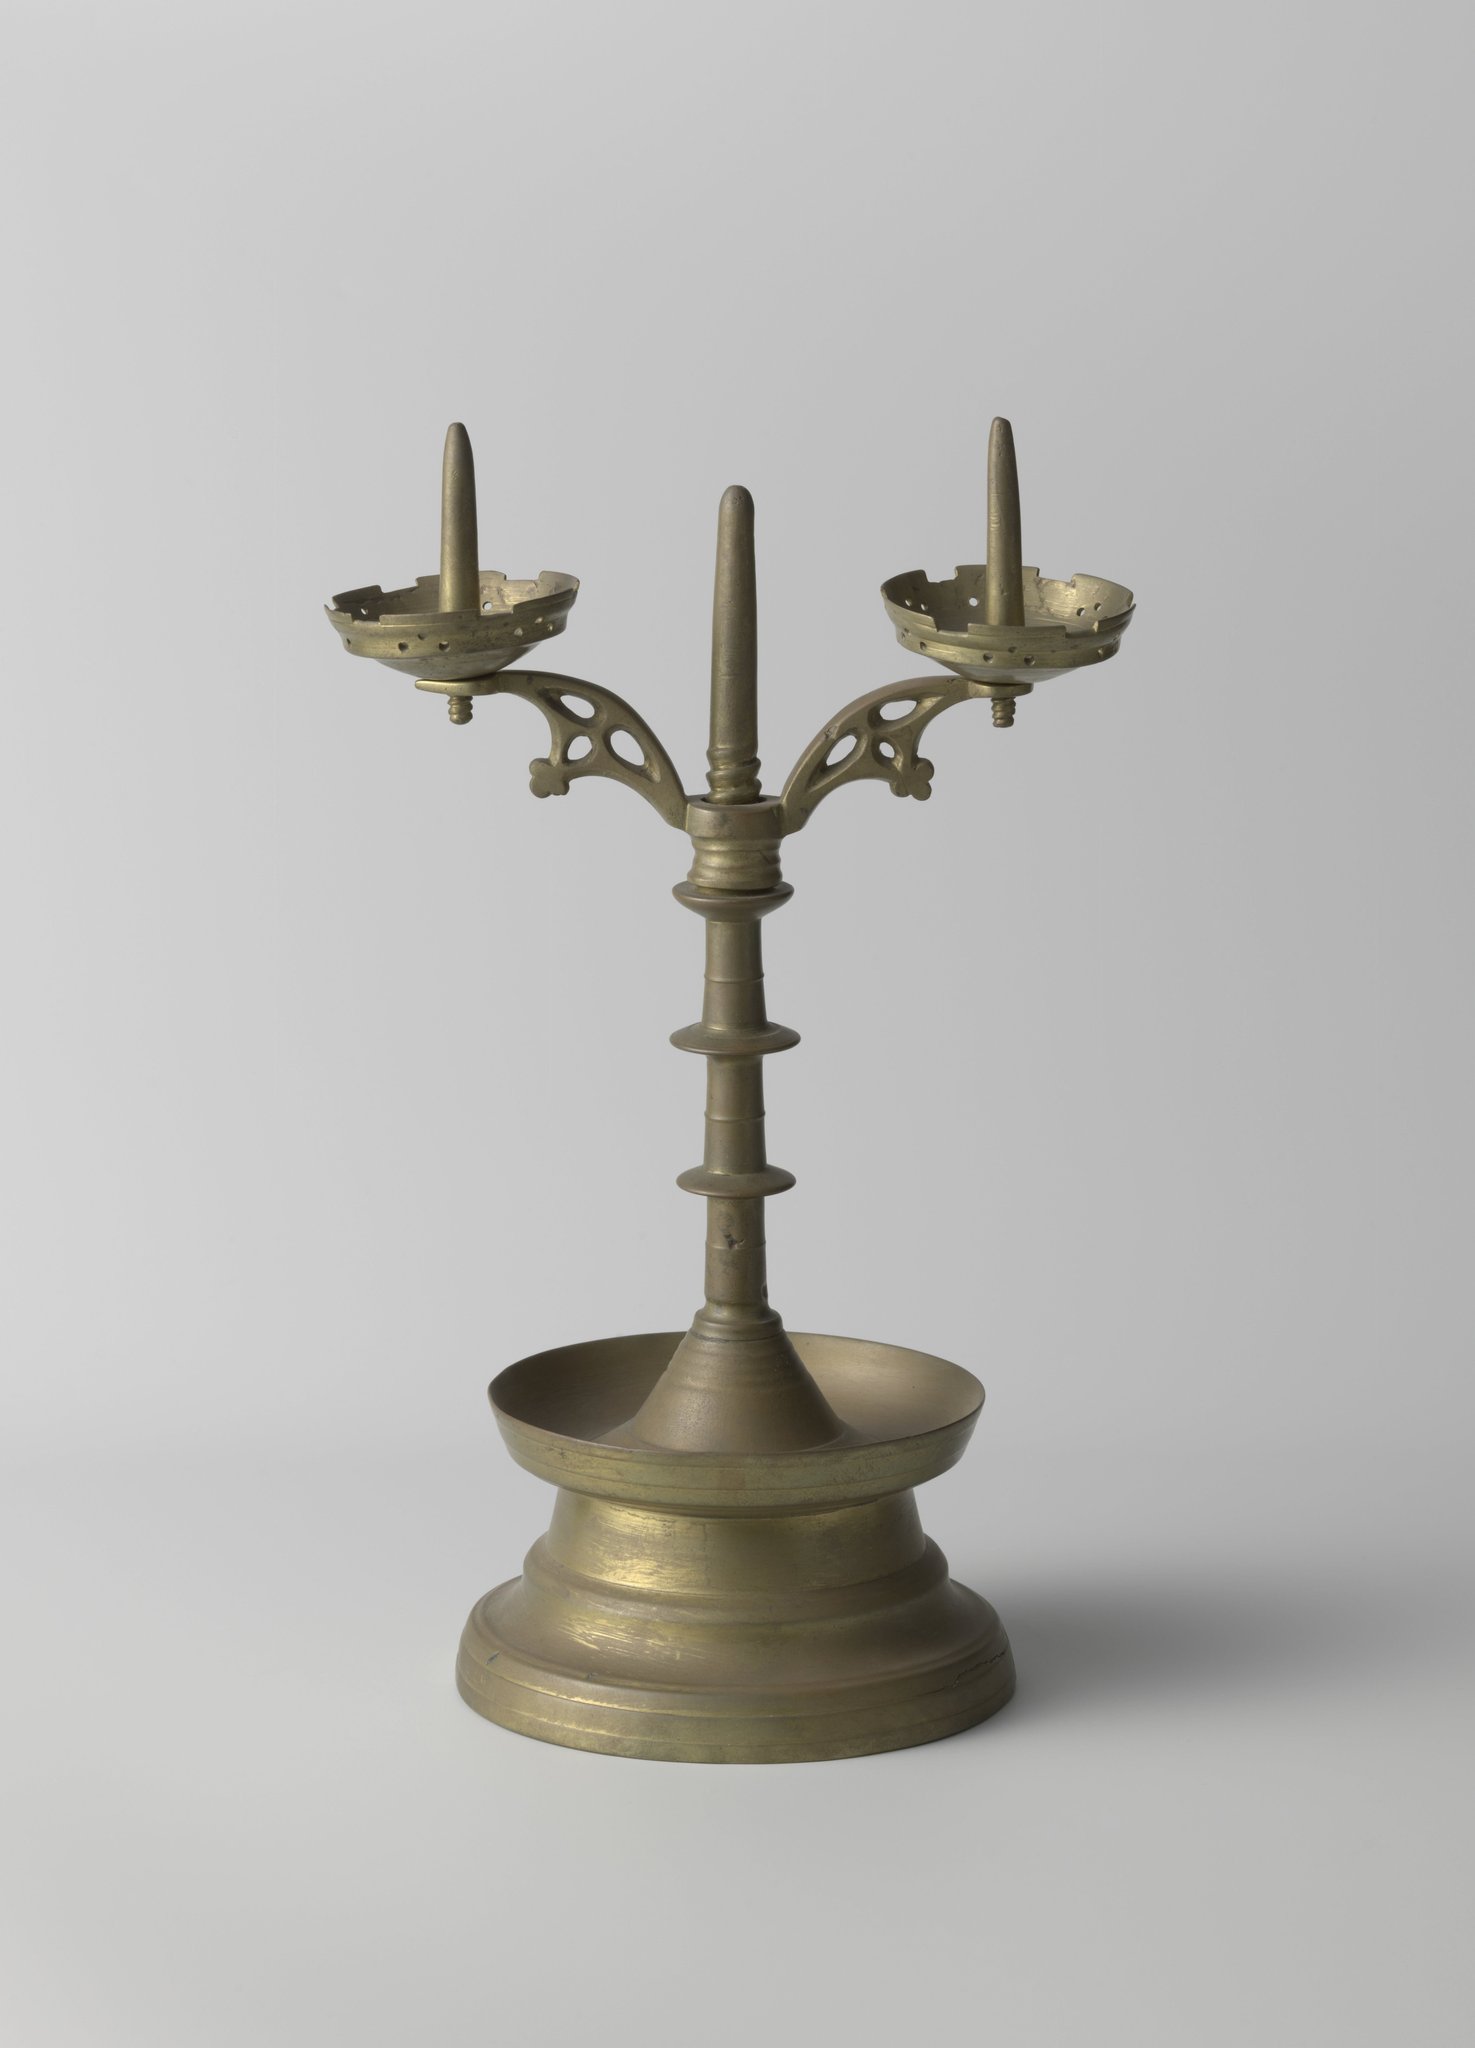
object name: candlestick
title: Kandelaar met twee armen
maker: Anonymous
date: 1450-1500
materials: brass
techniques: casting, screwed, turning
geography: southern netherlands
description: De geprofileerde konische voet heeft bovenaan een opstaande rand, waardoor hij tevens als vetvanger dienst kan doen. Op de voet is de ronde stam geklonken, die met drie knopen is versierd. Het bovendeel van de stam, dat gedeeltelijk van een schroefdraad is voorzien, loopt zodanig toe dat het als een kaarsenpin kan worden gebruikt. De overgang van de voet naar de stam is door rillen gemarkeerd. Op de stam is de twee-armige draaier geplaatst, welke in het midden een rond gat heeft met een schroefdraad, die past op die van de schacht. De armen hebben de vorm van driepassen. In de ronde of puntvormig toelopende uiteinden zijn de kaarsenpinnen op de vetvangers geschroefd. Deze laatste hebben zes kantelen en zijn versierd met zes ornamentjes van telkens drie gaatjes.